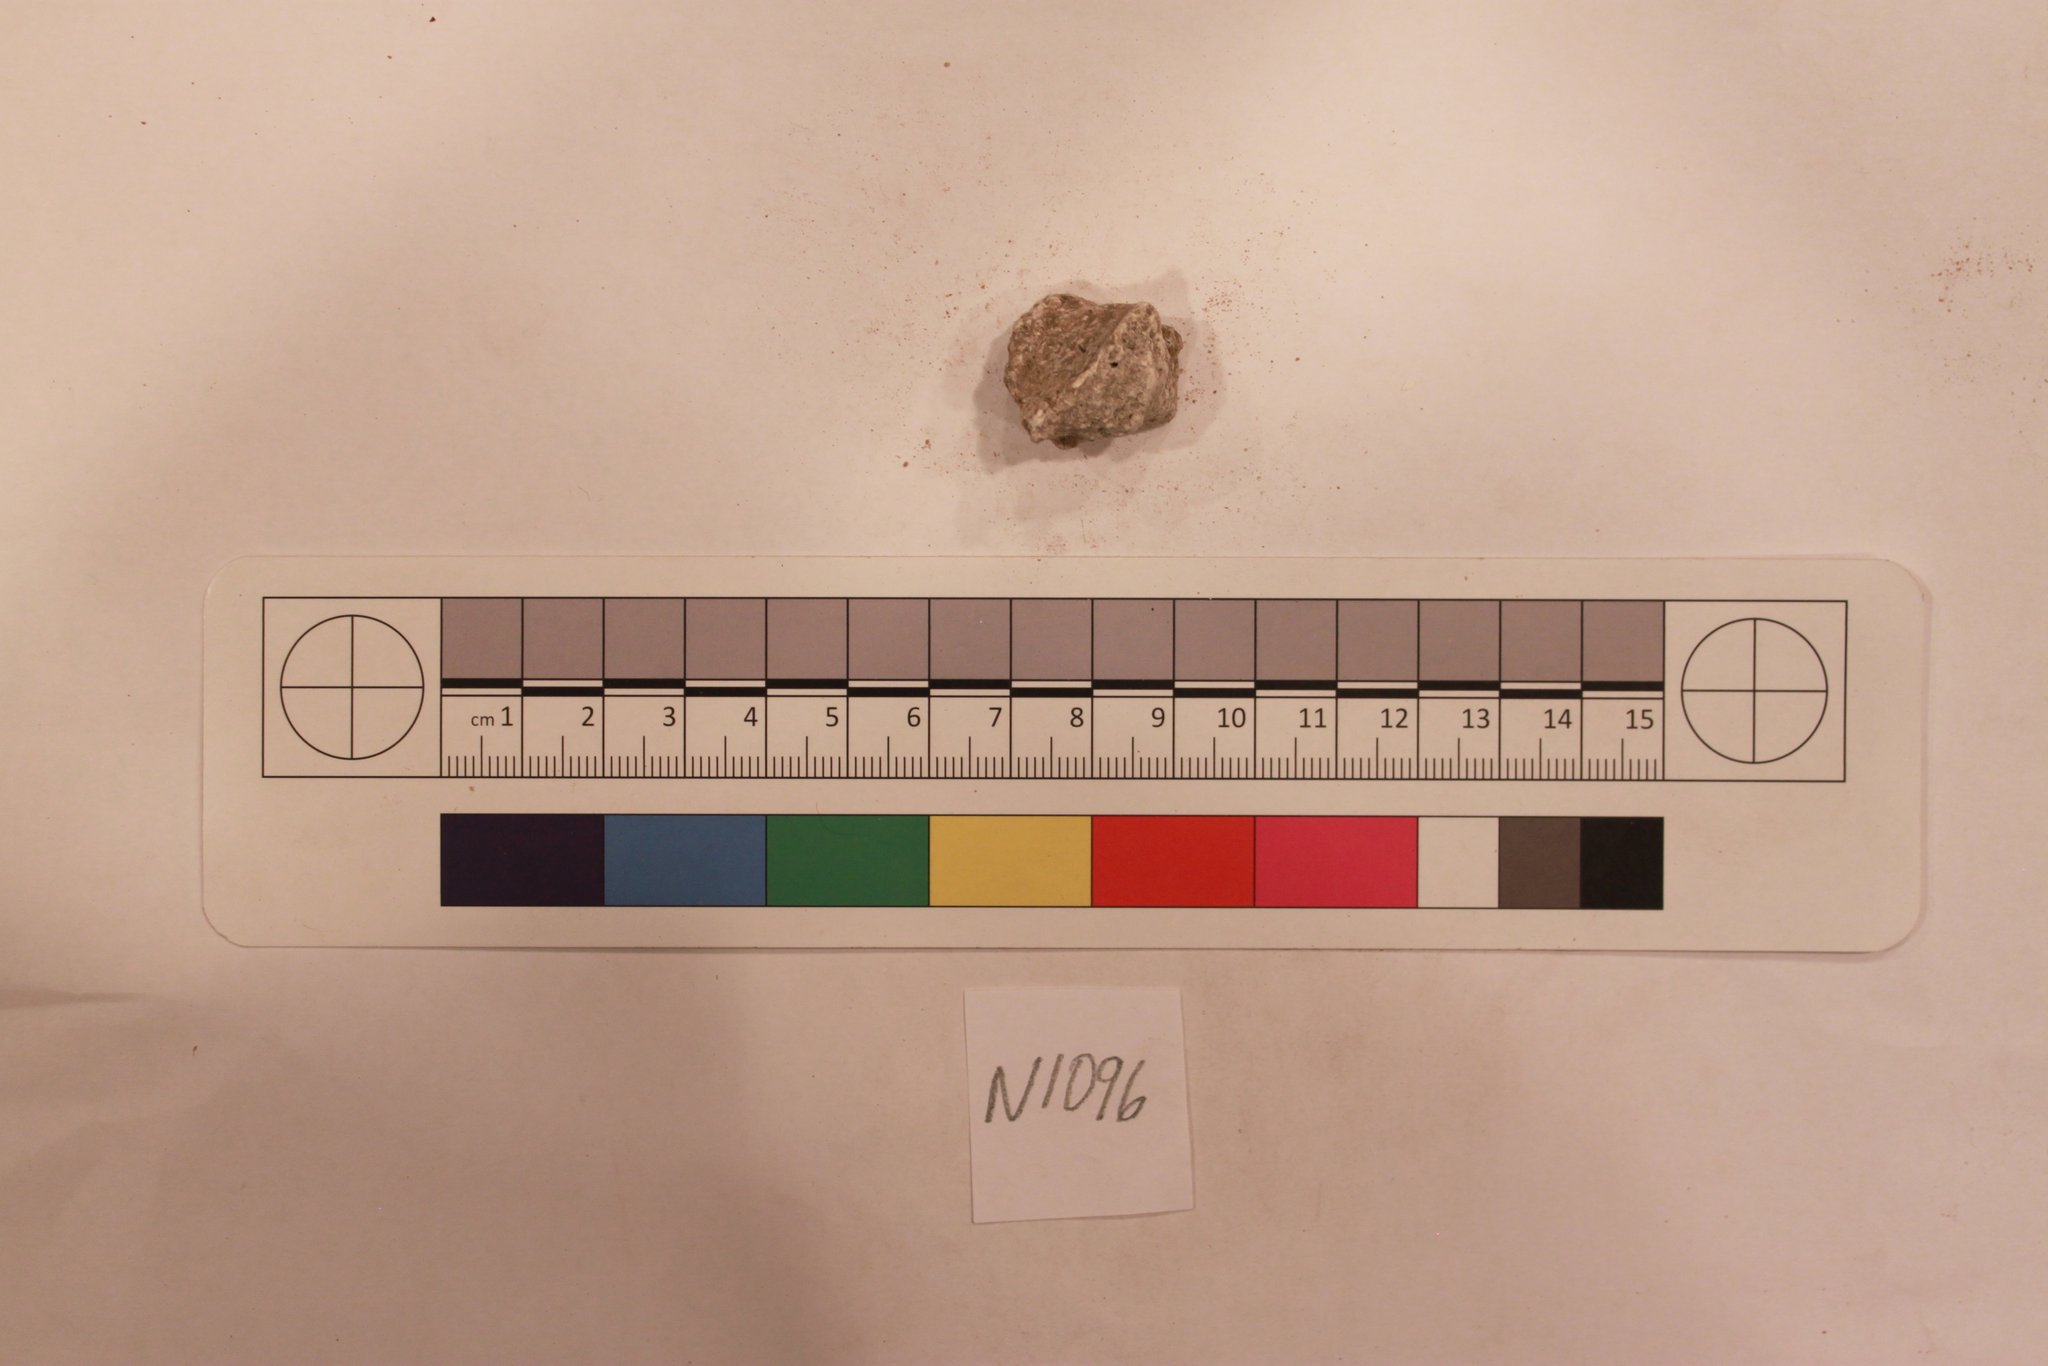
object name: fragment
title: Stucco Fragment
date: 701-1200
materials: plaster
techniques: carving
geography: iran